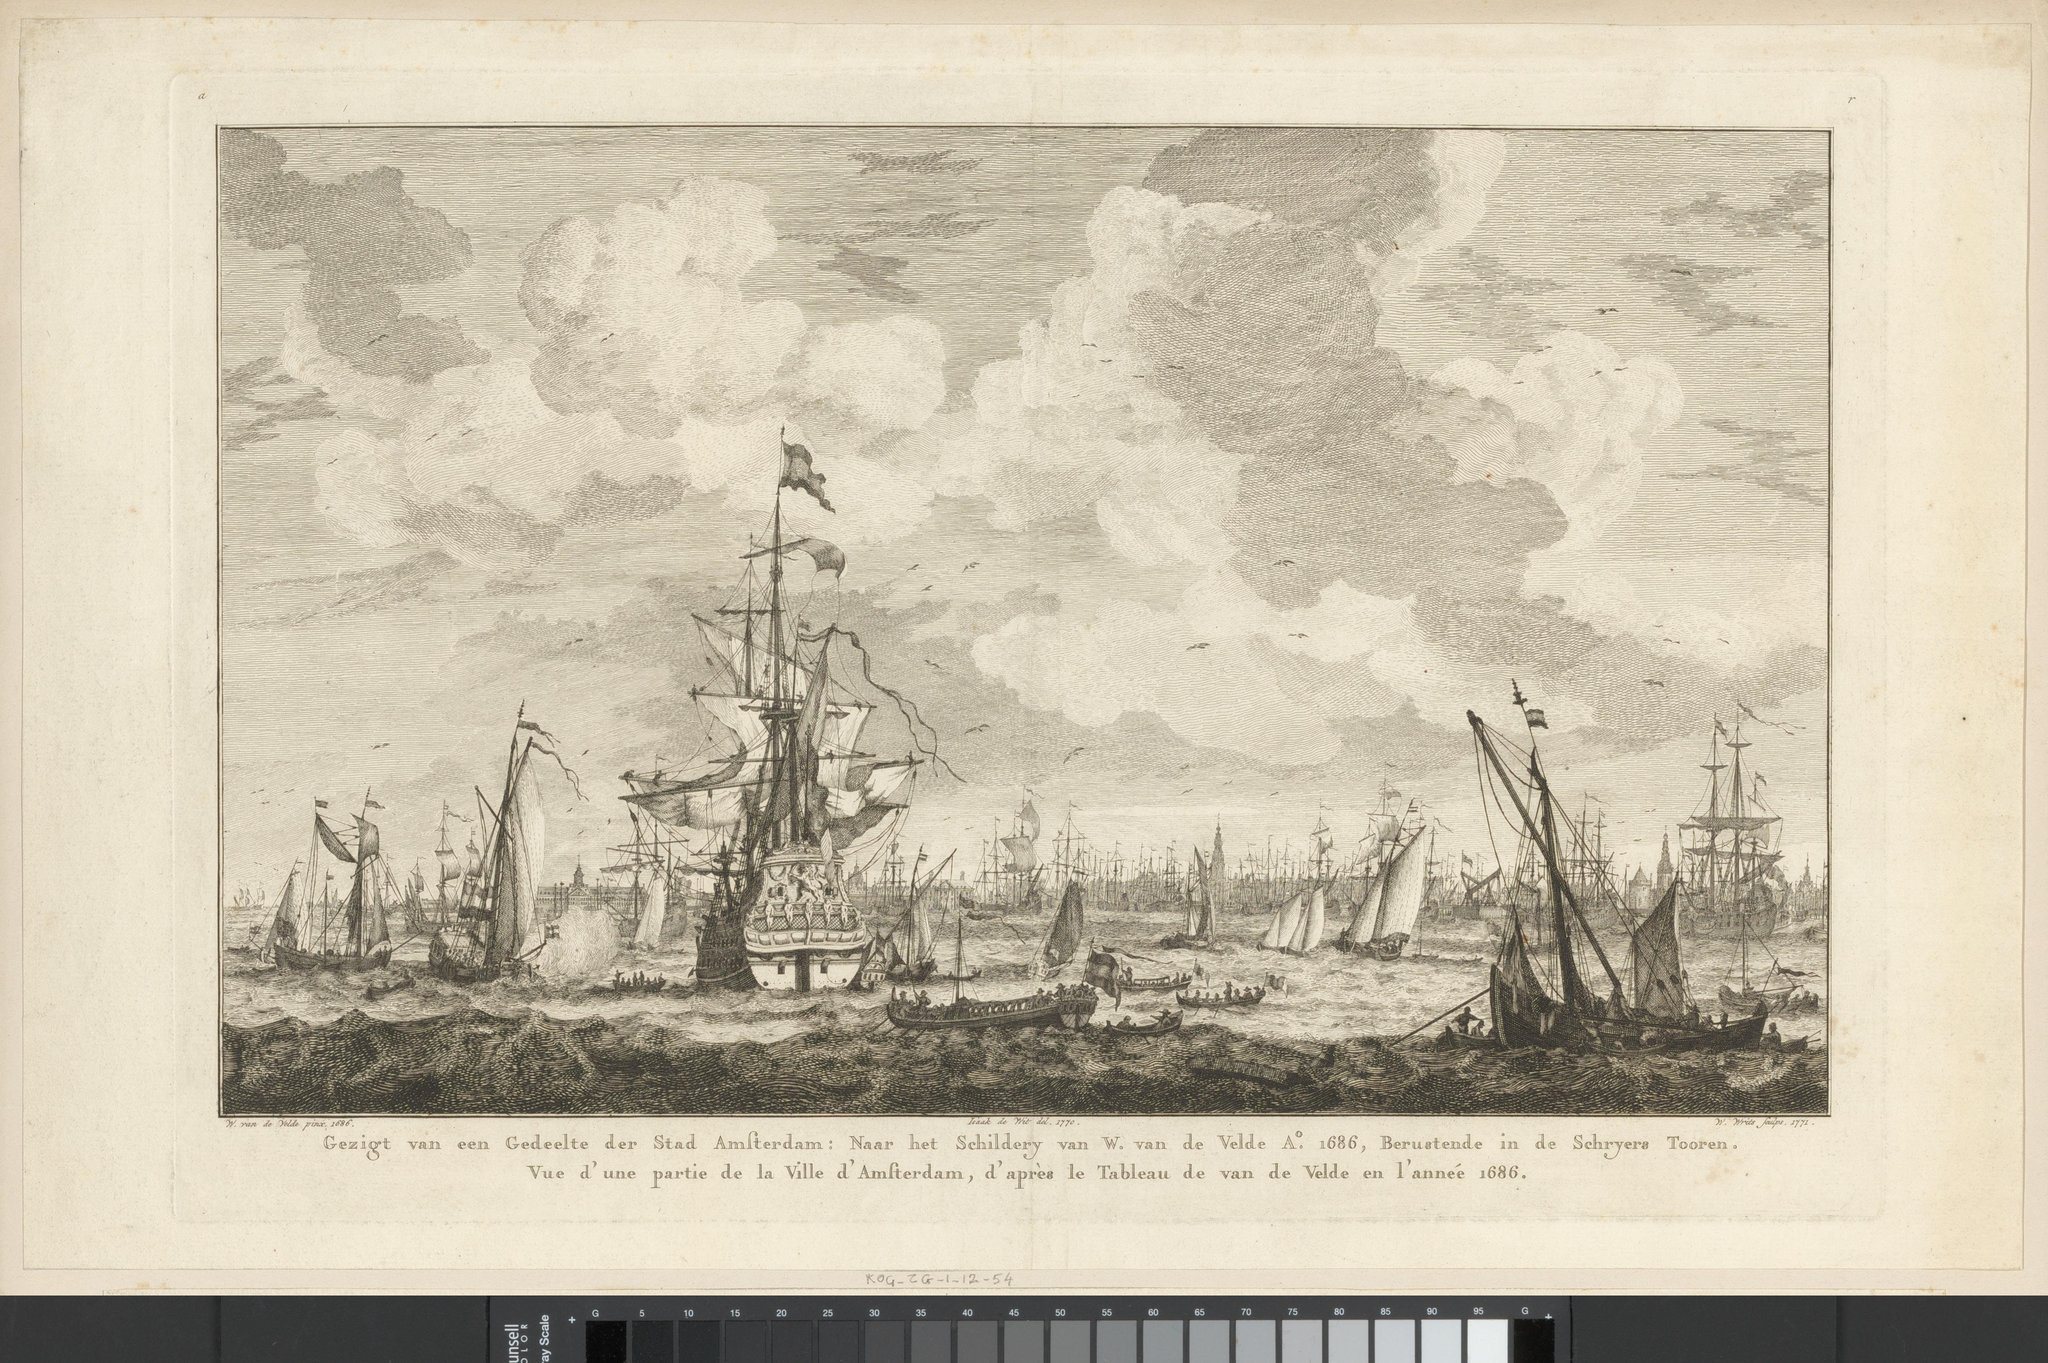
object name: print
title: Schepen op het IJ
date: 1771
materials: paper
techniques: engraving, etching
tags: sailing-ship, sailing-boat, rowing-boat, canoe, etc.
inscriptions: stamp, collector's mark: Lugt 1641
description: Schepen op het IJ, met op de achtergrond een profiel van de oostzijde van Amsterdam. Op de achtergrond van links naar rechts: de VOC-pakhuizen op Oostenburg, de Oosterkerk, 's-Lands Zeemagazijn, de Montelbaanstoren, de Scheepskranen, de Schreierstoren en Oudekerkstoren. Onderwerpsrubrieken binnen de Atlas Zeden en Gewoonten: Handel, Nijverheid en Verkeer, Scheepsvaart.